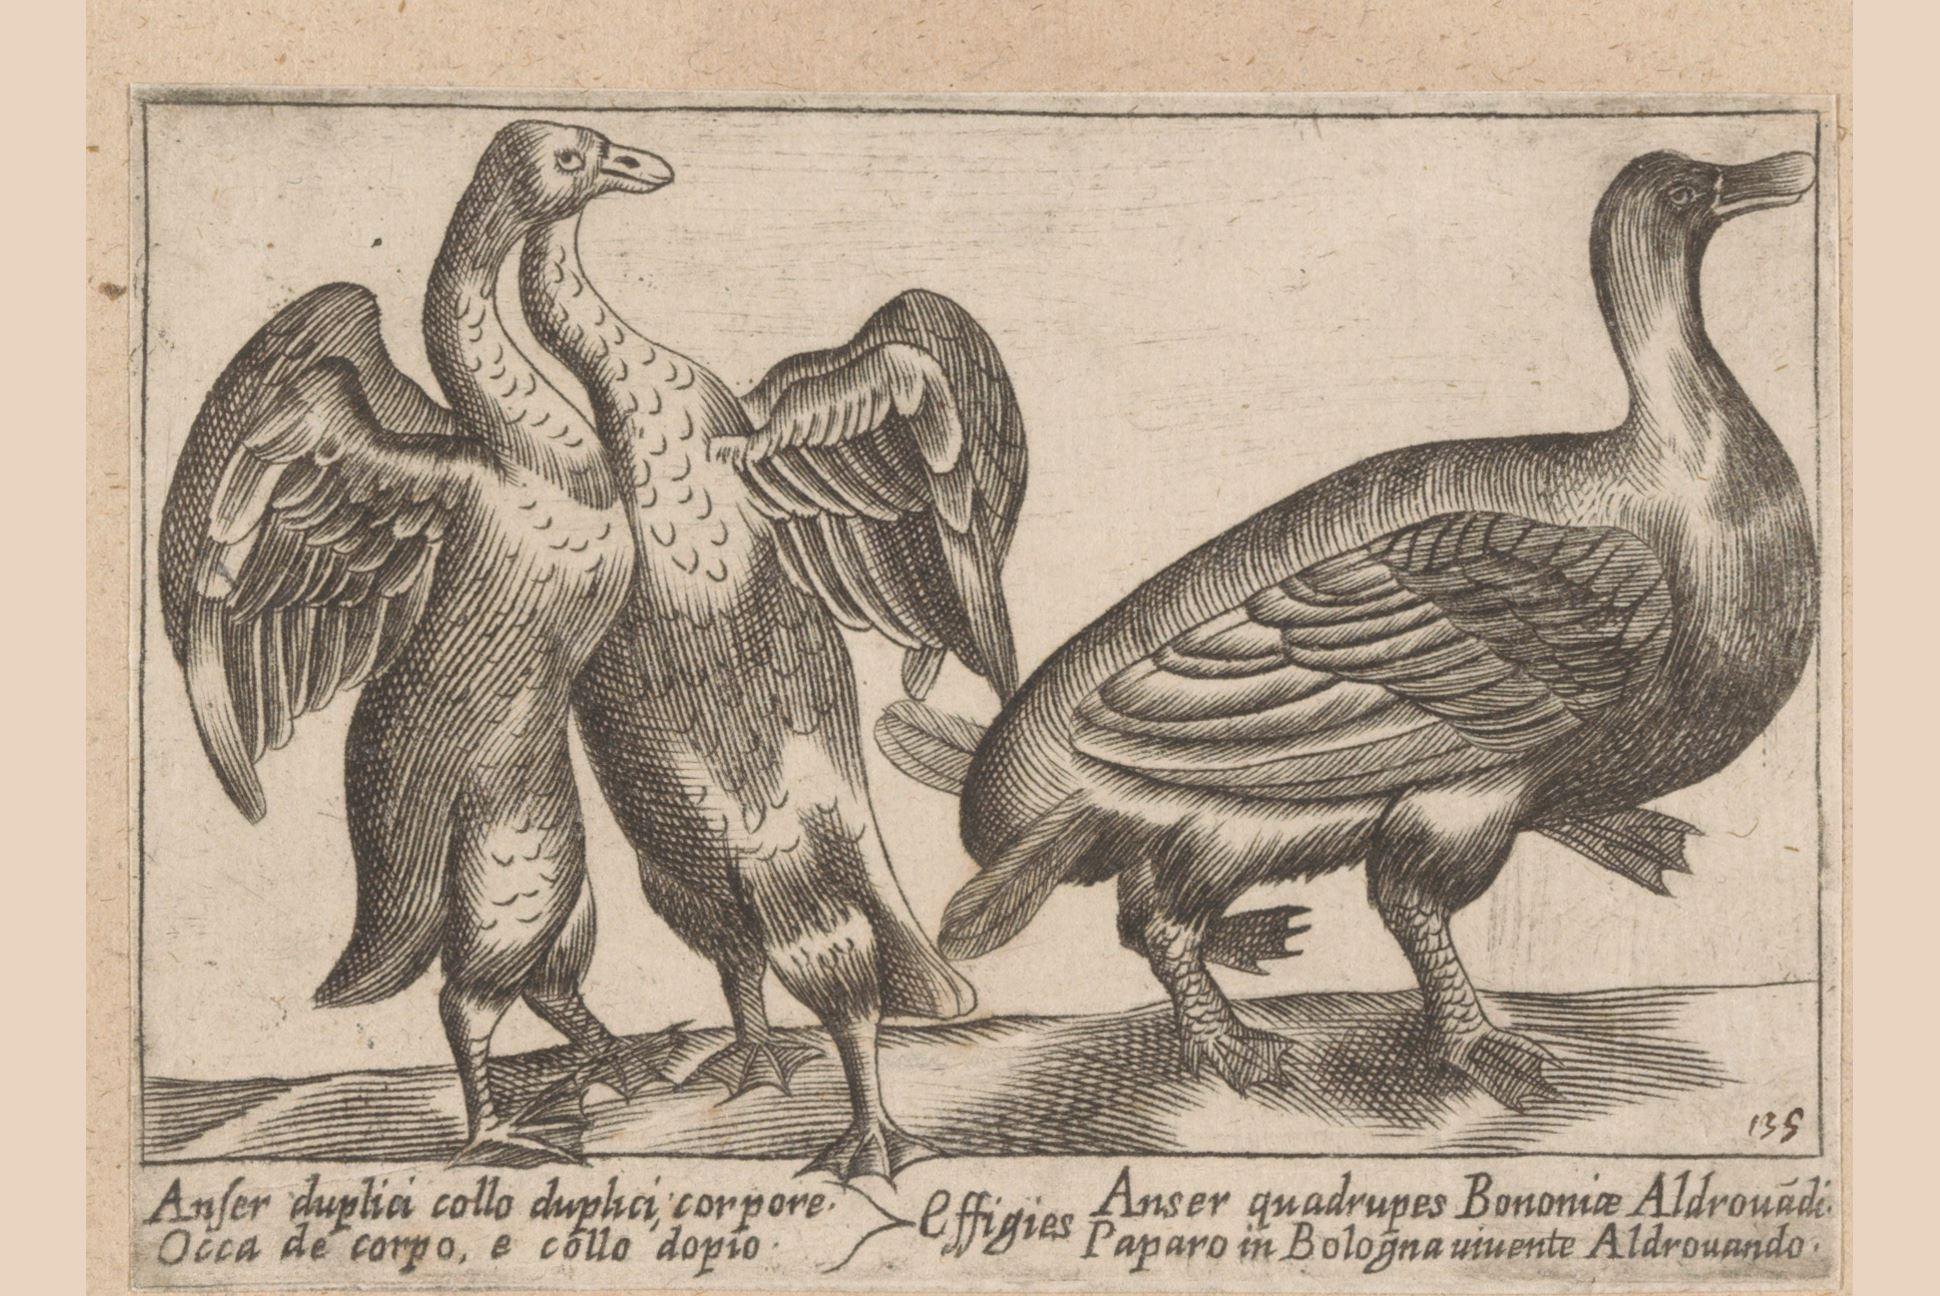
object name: print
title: Anser duplici collo duplici corpore/ / Effigies/ Anser quadrupes Bononiae Aldrovadi/ Occa de corpo, e collo dopio/ Paparo in Bologna vivente Aldrovando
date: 1565-1630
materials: paper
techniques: etching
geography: rome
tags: water-birds: goose, mis-shapen animals; monsters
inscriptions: number: ‘135’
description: Deze prent maakt deel uit van een reeks prenten van dieren door Antonio Tempesta. Bekend is dat een tweede staat (met nummering) van deze serie is uitgegeven door Giovanni Giacomo de' Rossi in 1650. Onbekend is wie de eerste staat heeft uitgegeven en wanneer.